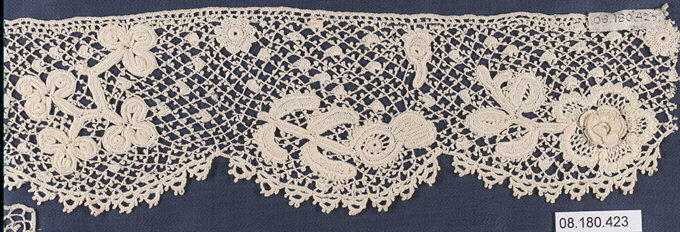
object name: fragment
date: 1801-1900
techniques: crochet